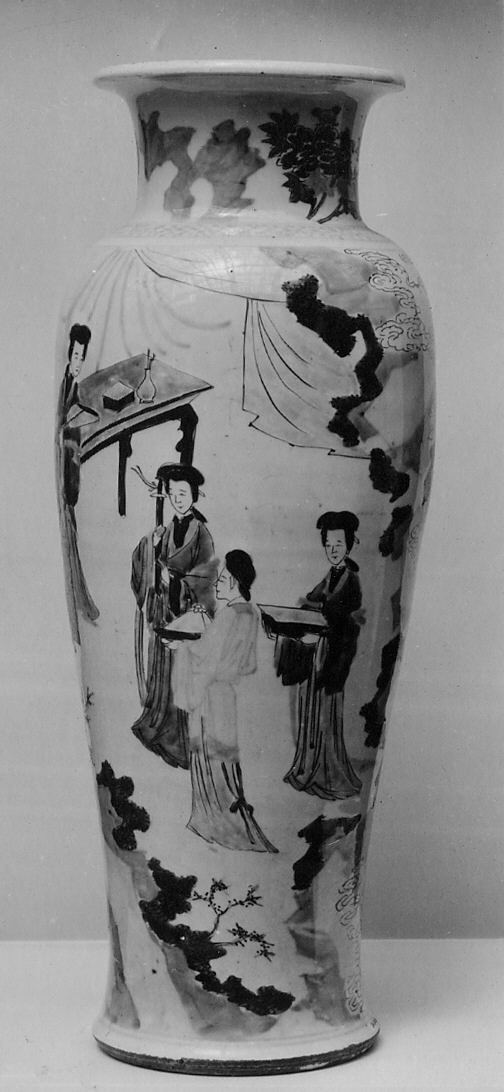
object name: vase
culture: chinese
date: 1601-1633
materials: enamel, porcelain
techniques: overglaze, painting, underglaze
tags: human figures